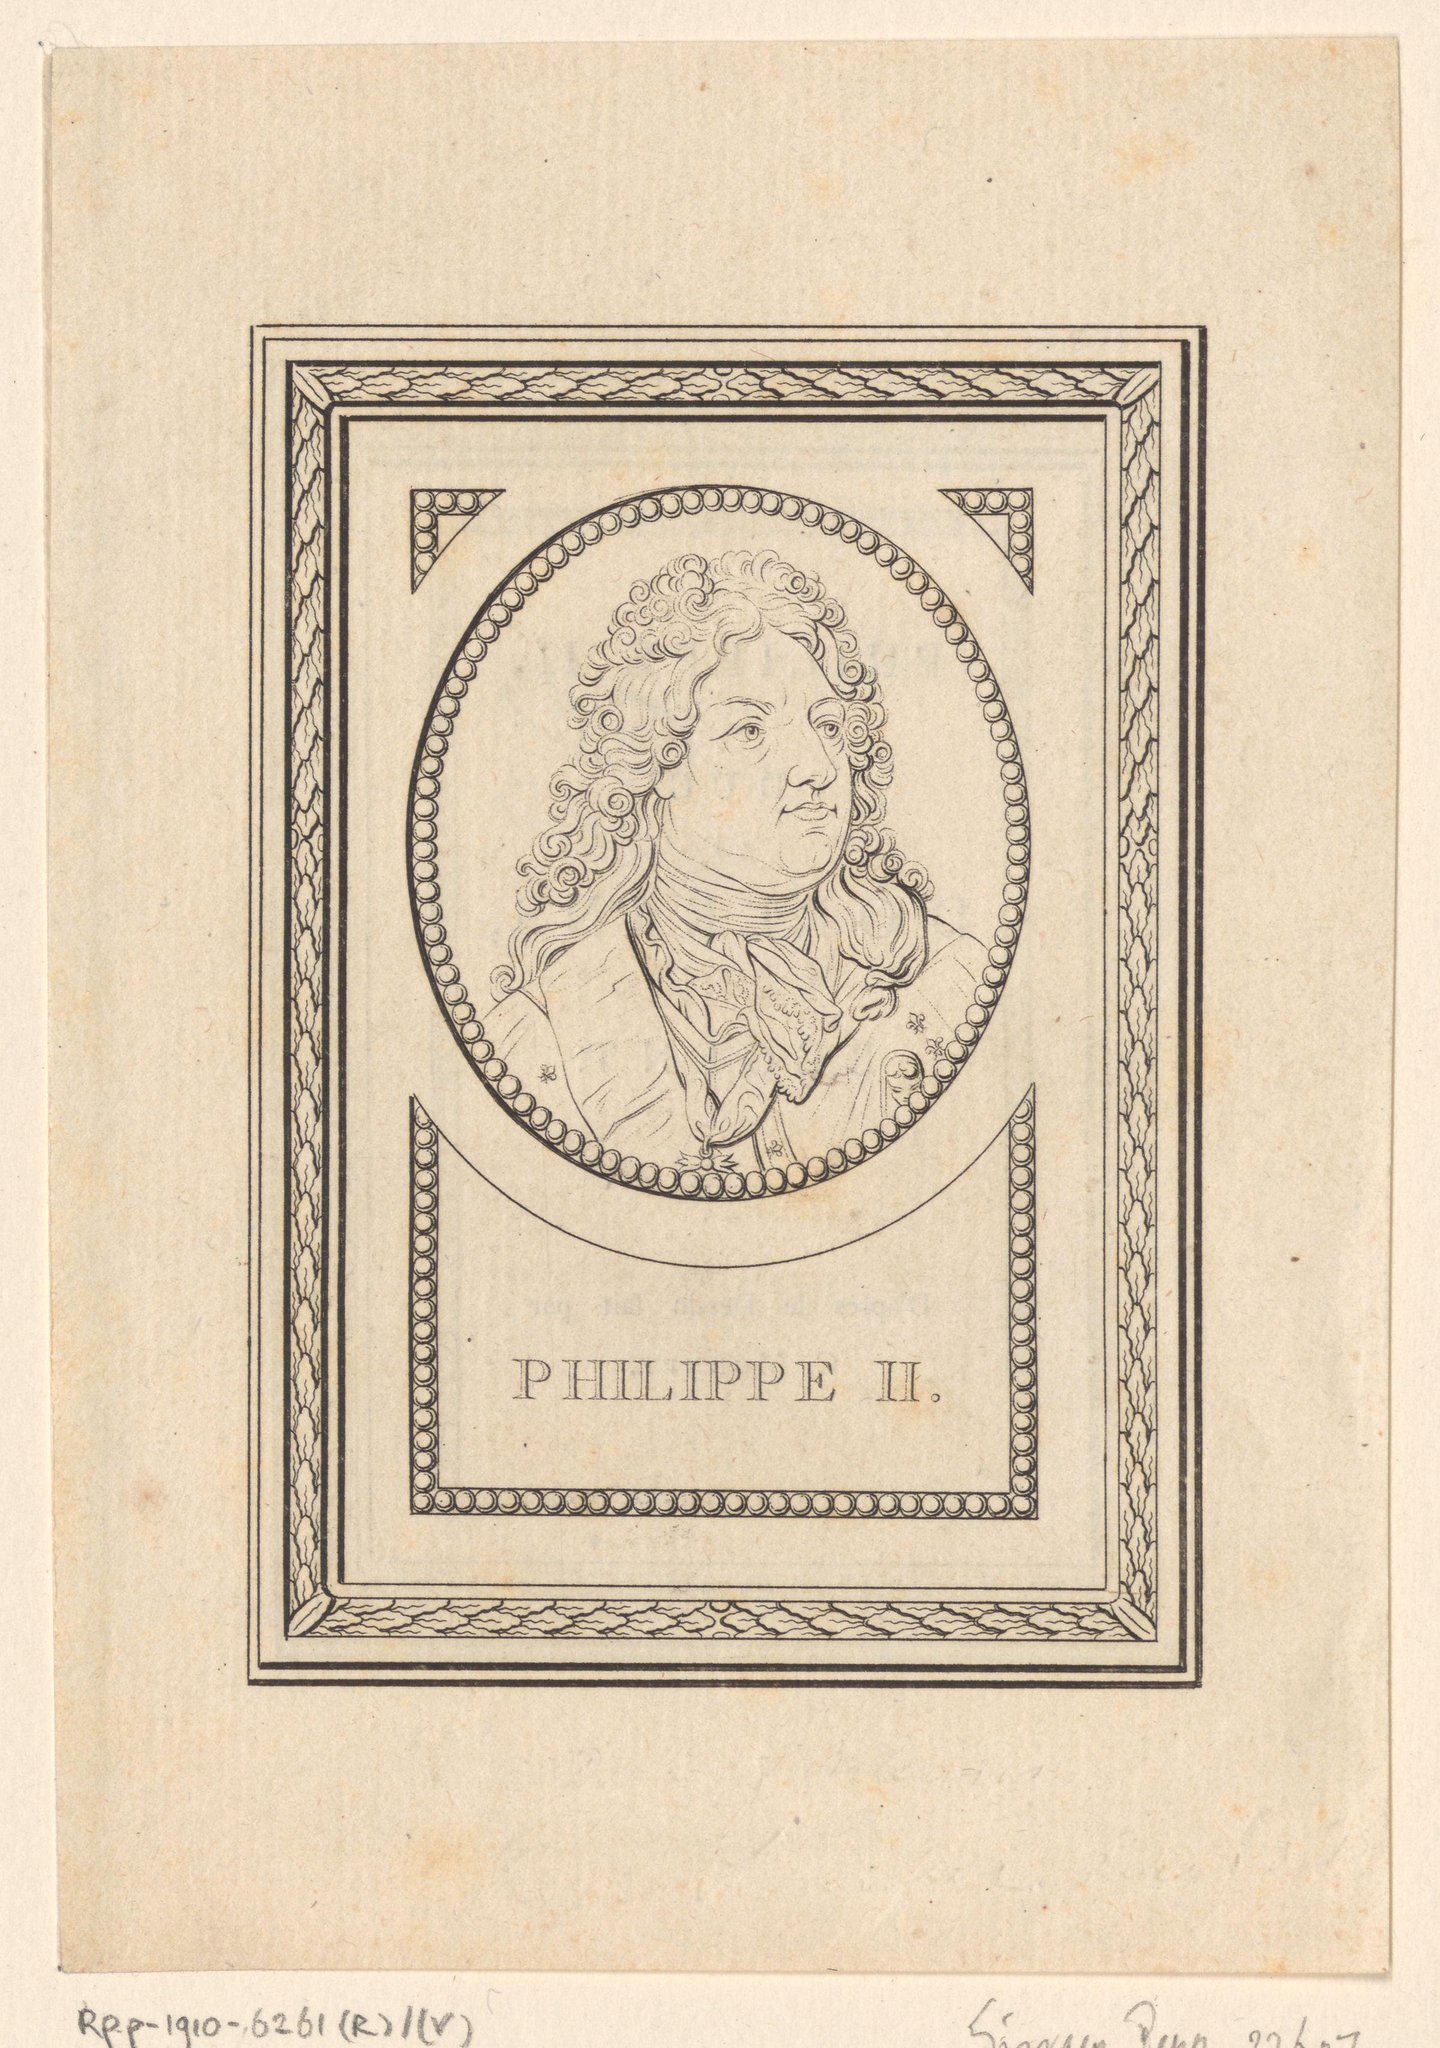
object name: print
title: Portret van Filips II, hertog van Orléans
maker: claude monnet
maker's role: print maker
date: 1700-1749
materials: paper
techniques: engraving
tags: filips ii (hertog van orléans), adult man, historical persons